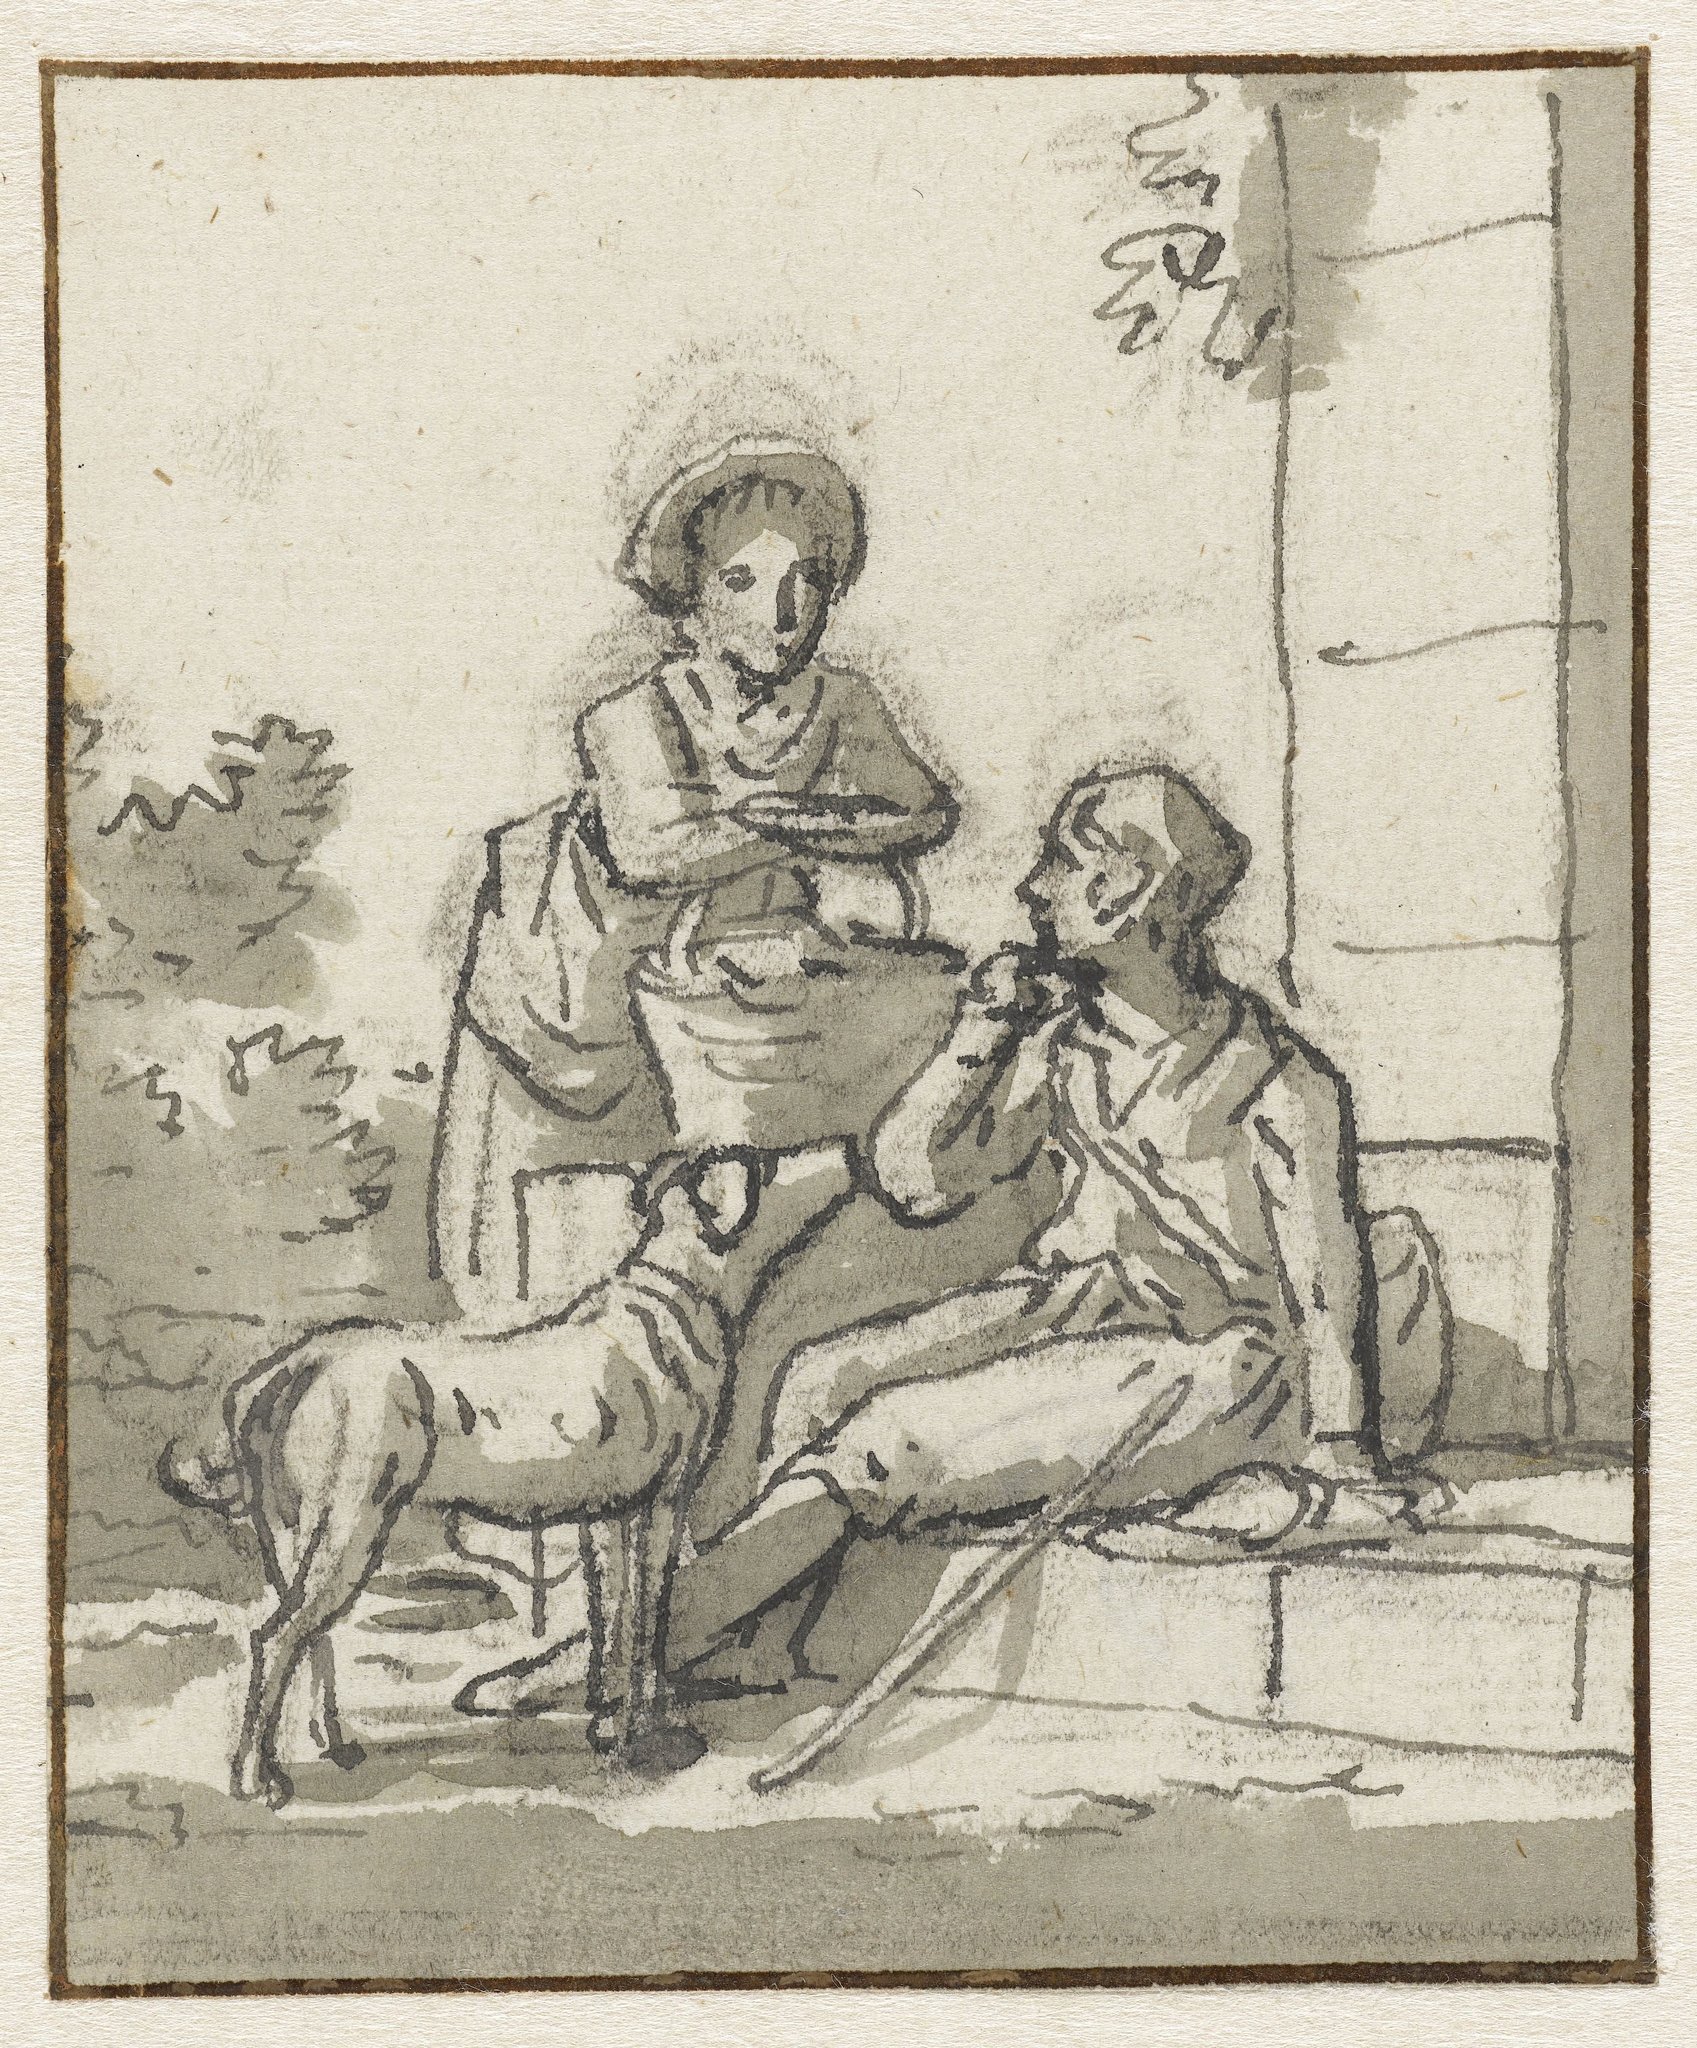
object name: drawing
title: Staande vrouw bij zittende man met hond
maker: jurriaan andriessen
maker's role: draughtsman, painter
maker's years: 1742-1819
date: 1752-1819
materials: chalk, ink, paper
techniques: brush, pen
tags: dog